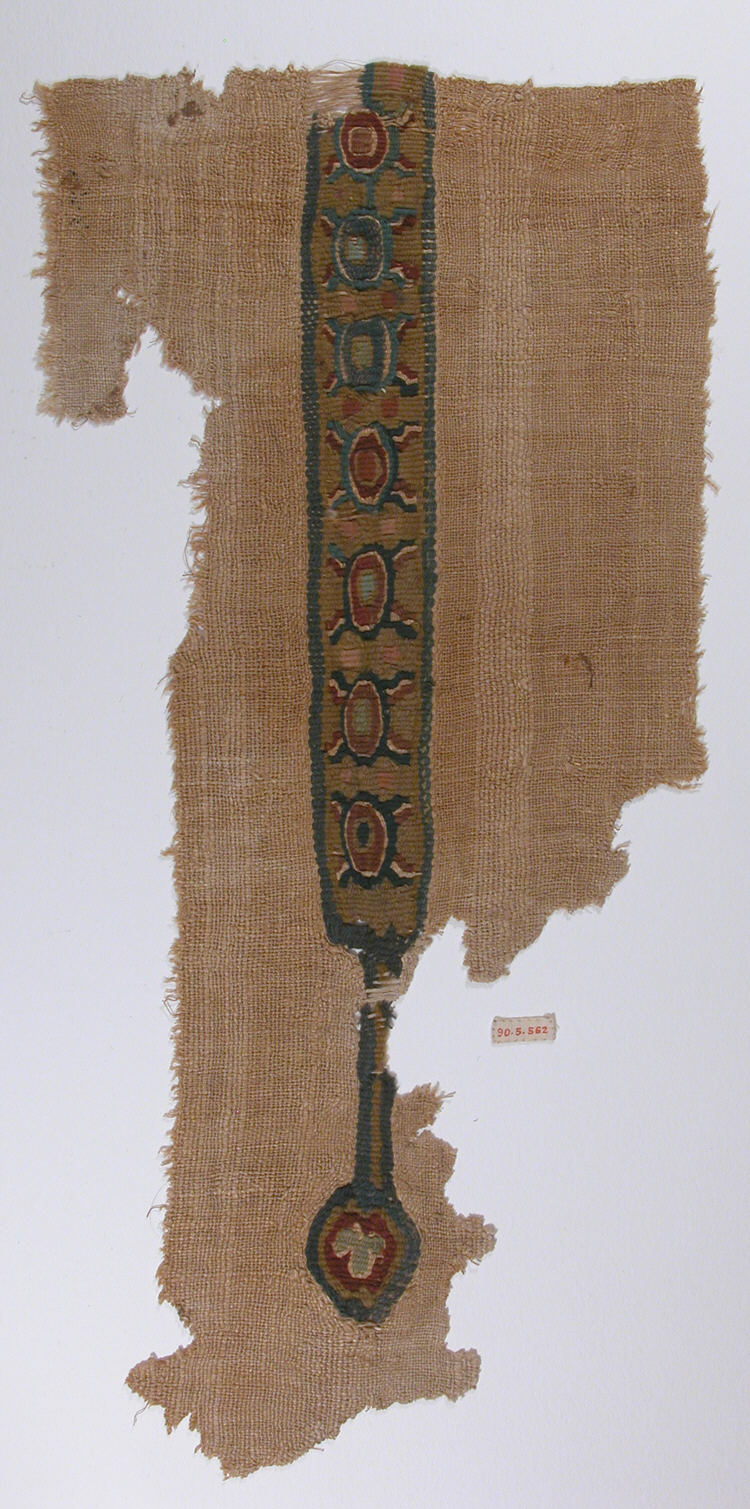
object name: textile fragment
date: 401-600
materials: linen, wool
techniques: weave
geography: egypt